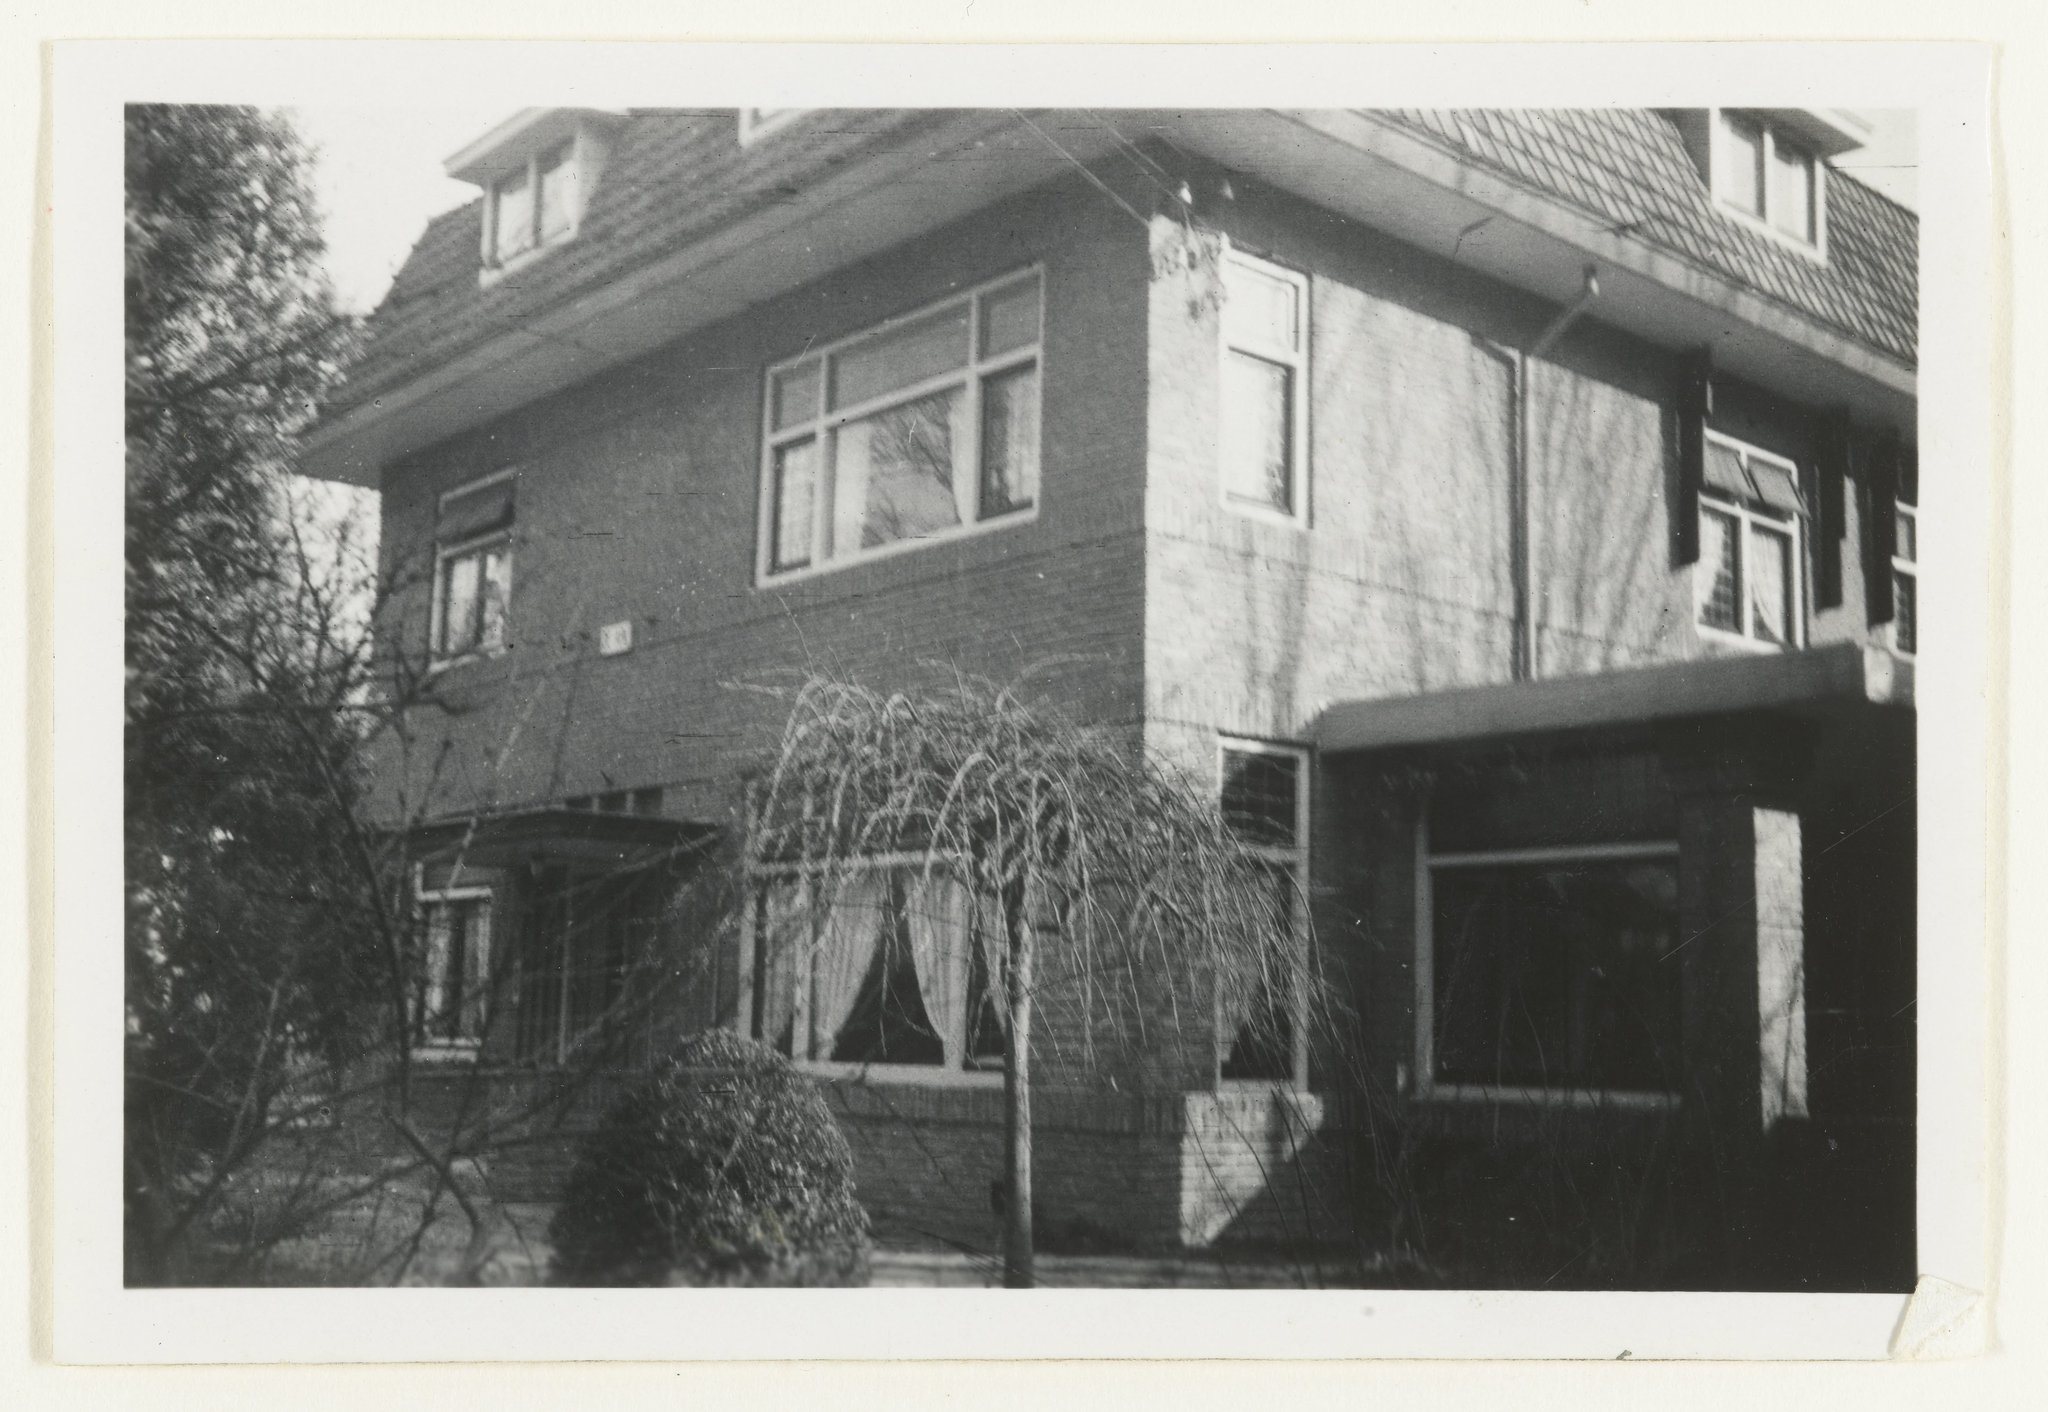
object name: photograph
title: Huis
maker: Anonymous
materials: photographic support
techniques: gelatin silver print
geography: netherlands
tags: occupier and civilians, occupation ~ war, netherlands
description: Een tamelijk groot huis met een treurberk ervoor. Links een boom.